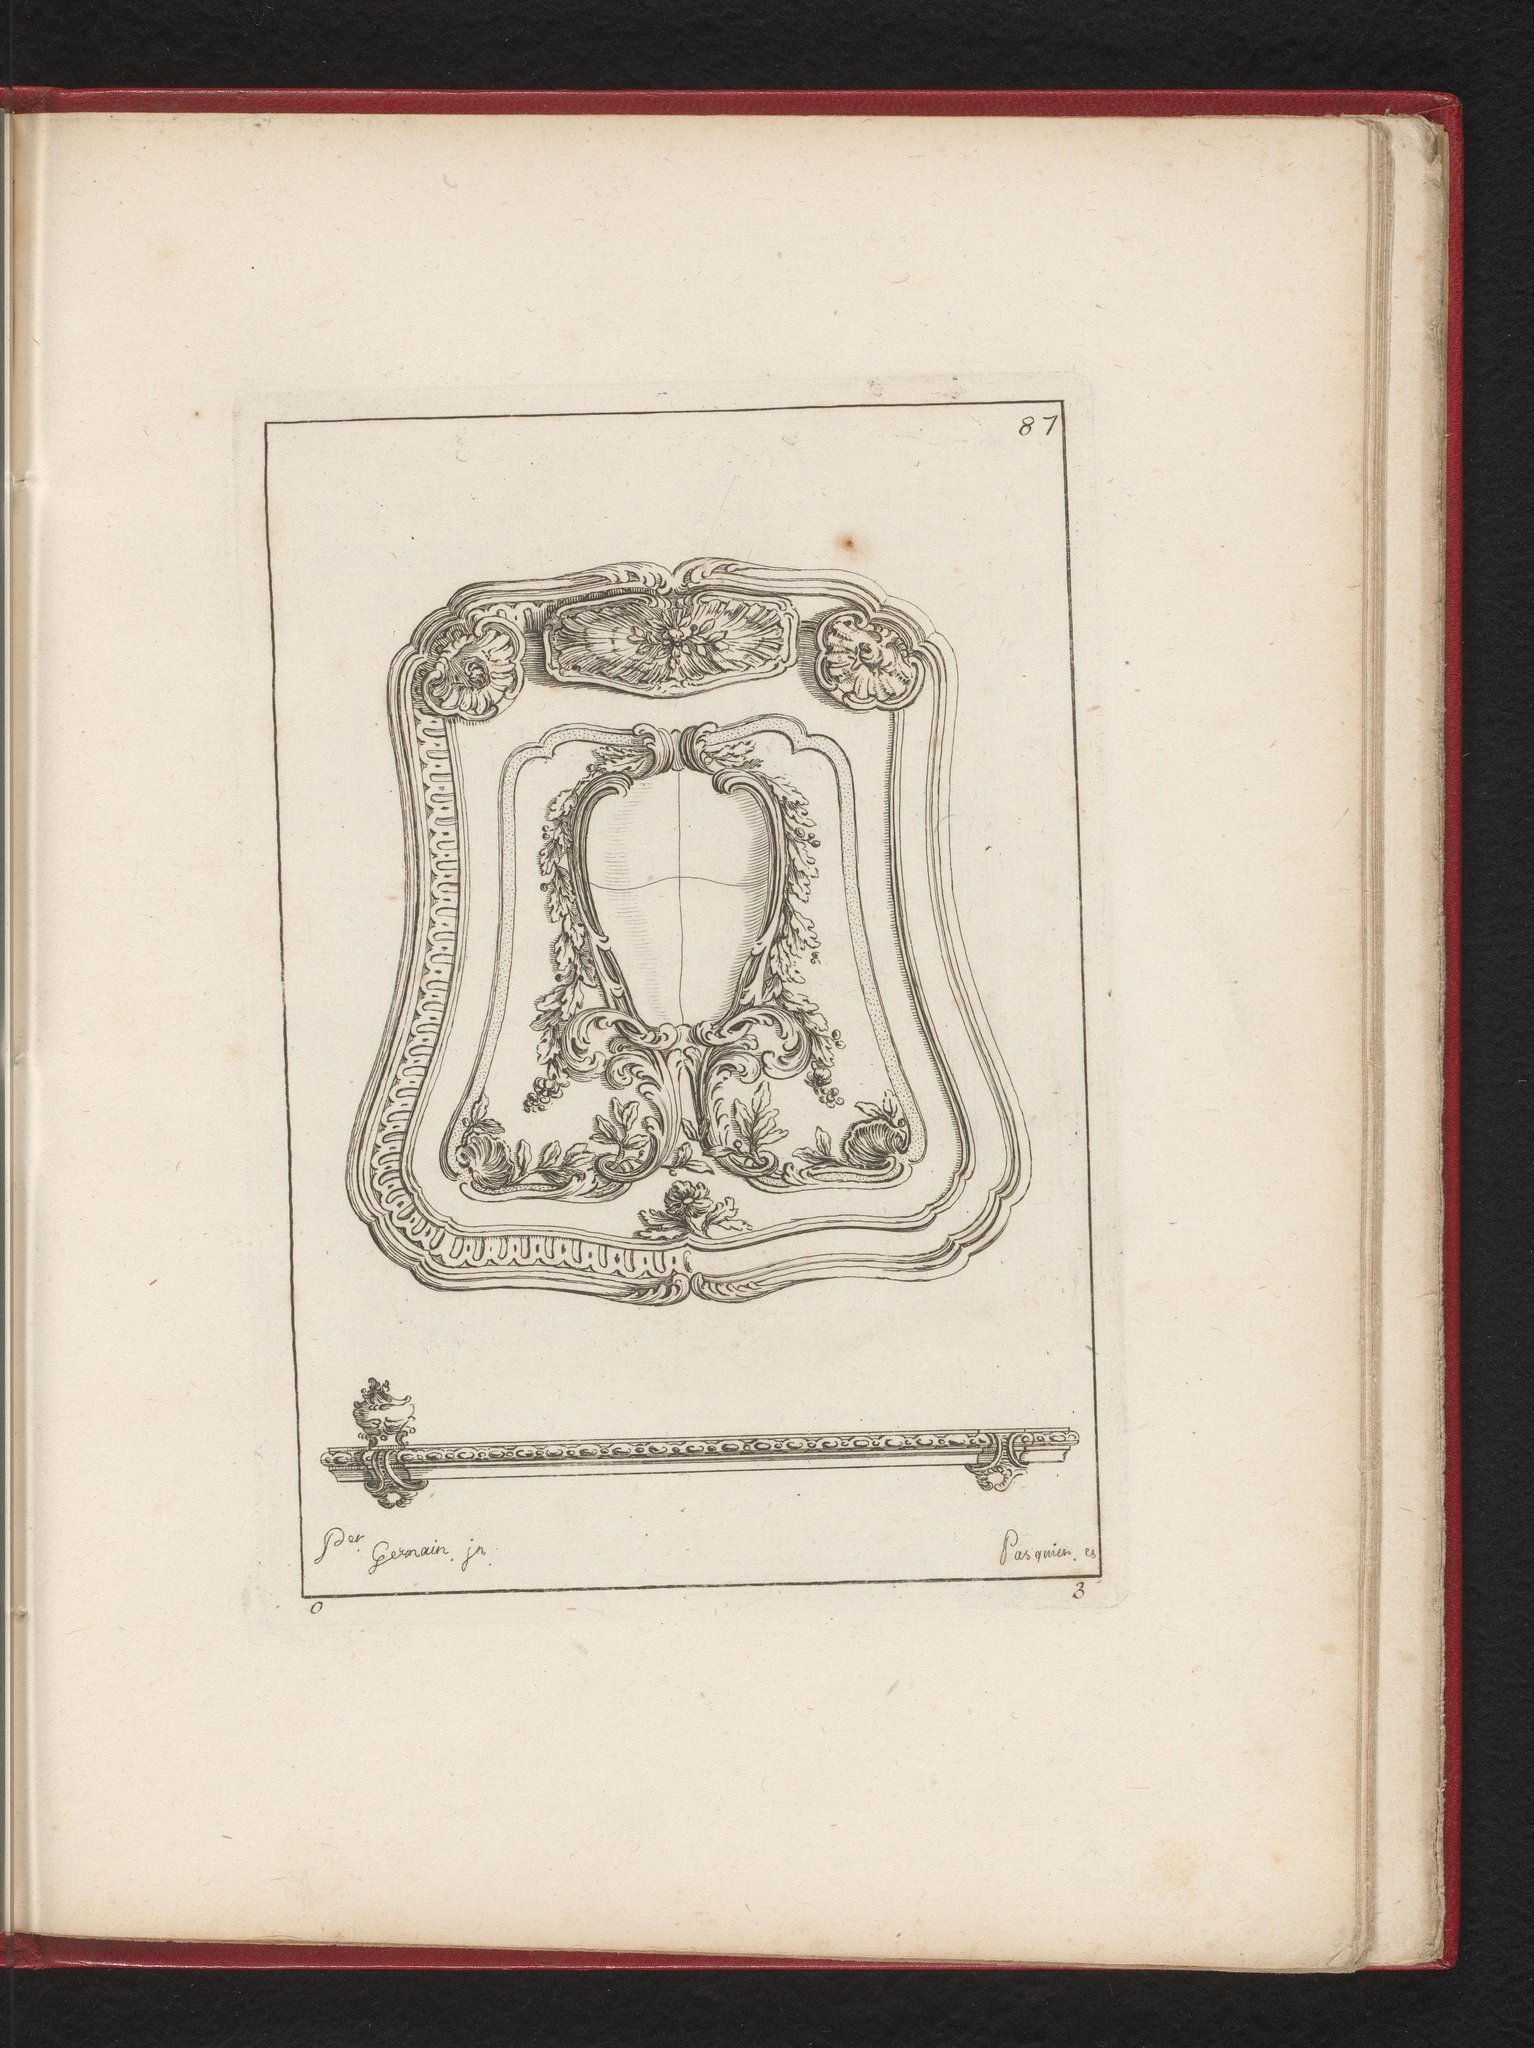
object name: album leaf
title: Ontwerp voor een decoratieve schaal of plaat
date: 1748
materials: paper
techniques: etching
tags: serving-dish, platter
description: Een aantal van de objecten in deze reeks heeft een eigen ondertitel, die verwijst naar genummerde 'cahiers' (afleveringen) waarin de prenten werden uitgegeven. Het is onduidelijk welke objecten recies bij welke aflevering horen. Daarom is die ondertitel enkel verwerkt bij de prent waarop die voorkomt.